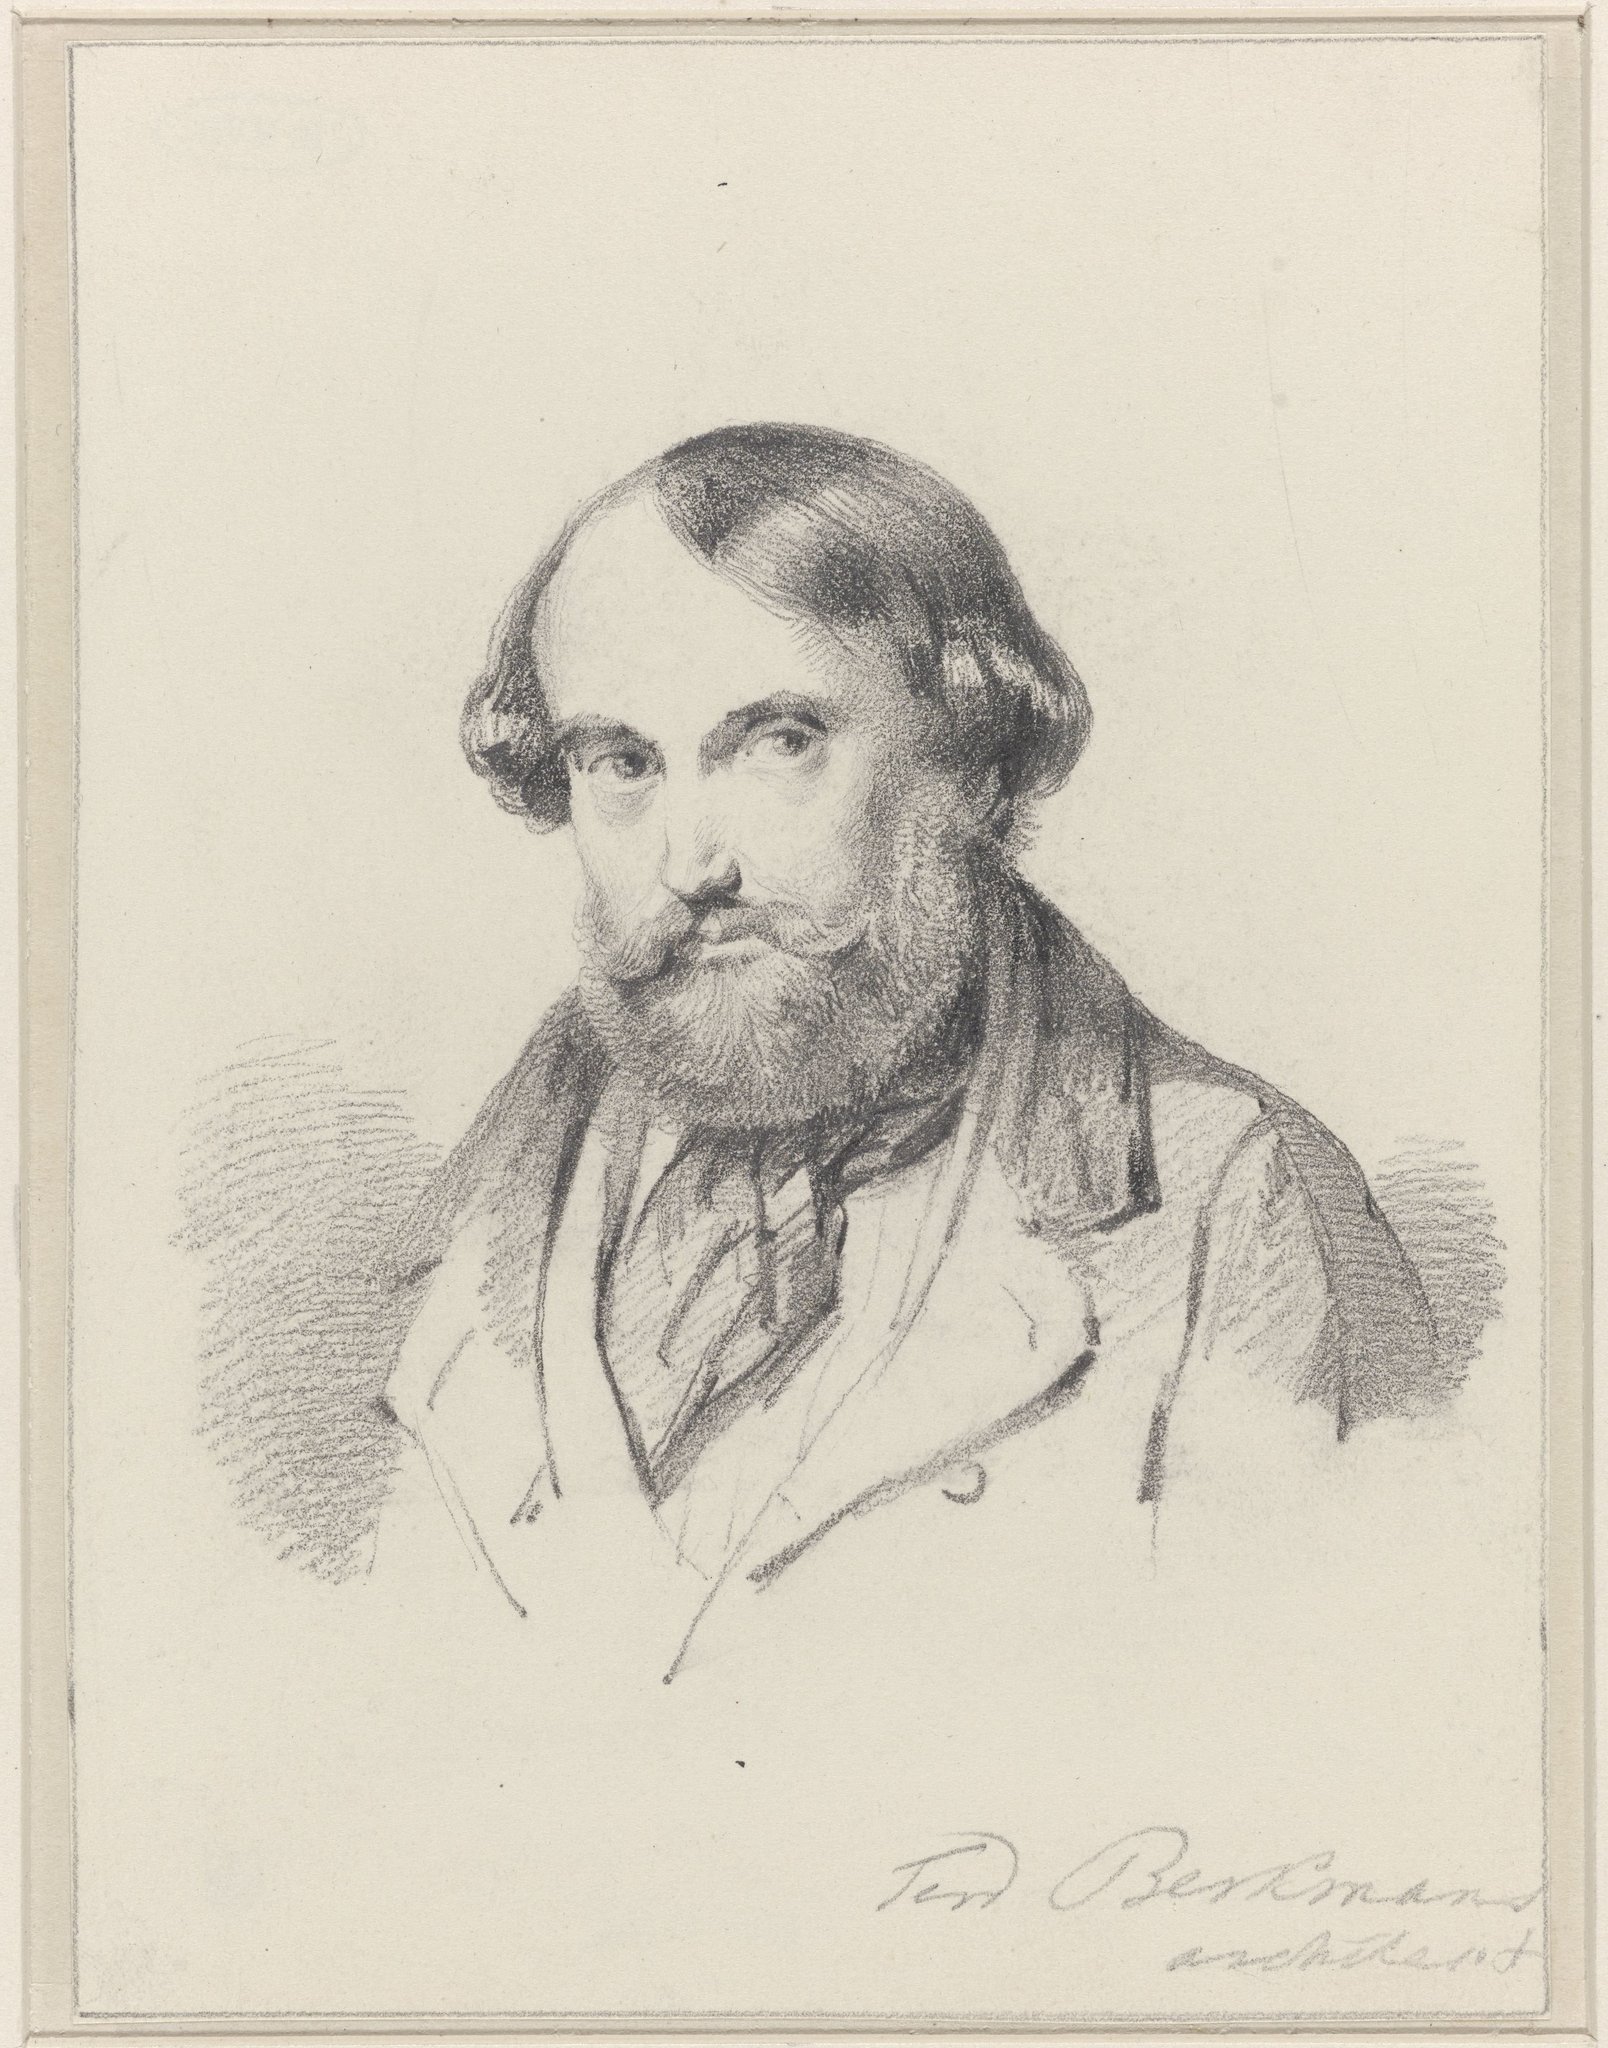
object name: drawing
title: Portret van Ferdinand Berkmans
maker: ferdinand berkmans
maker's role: draughtsman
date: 1800-1900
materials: paper, pencil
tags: ferdinand berkmans, historical persons, portrait, self-portrait of architect, portrait, self-portrait of artist, portrait, self-portrait of draughtsman